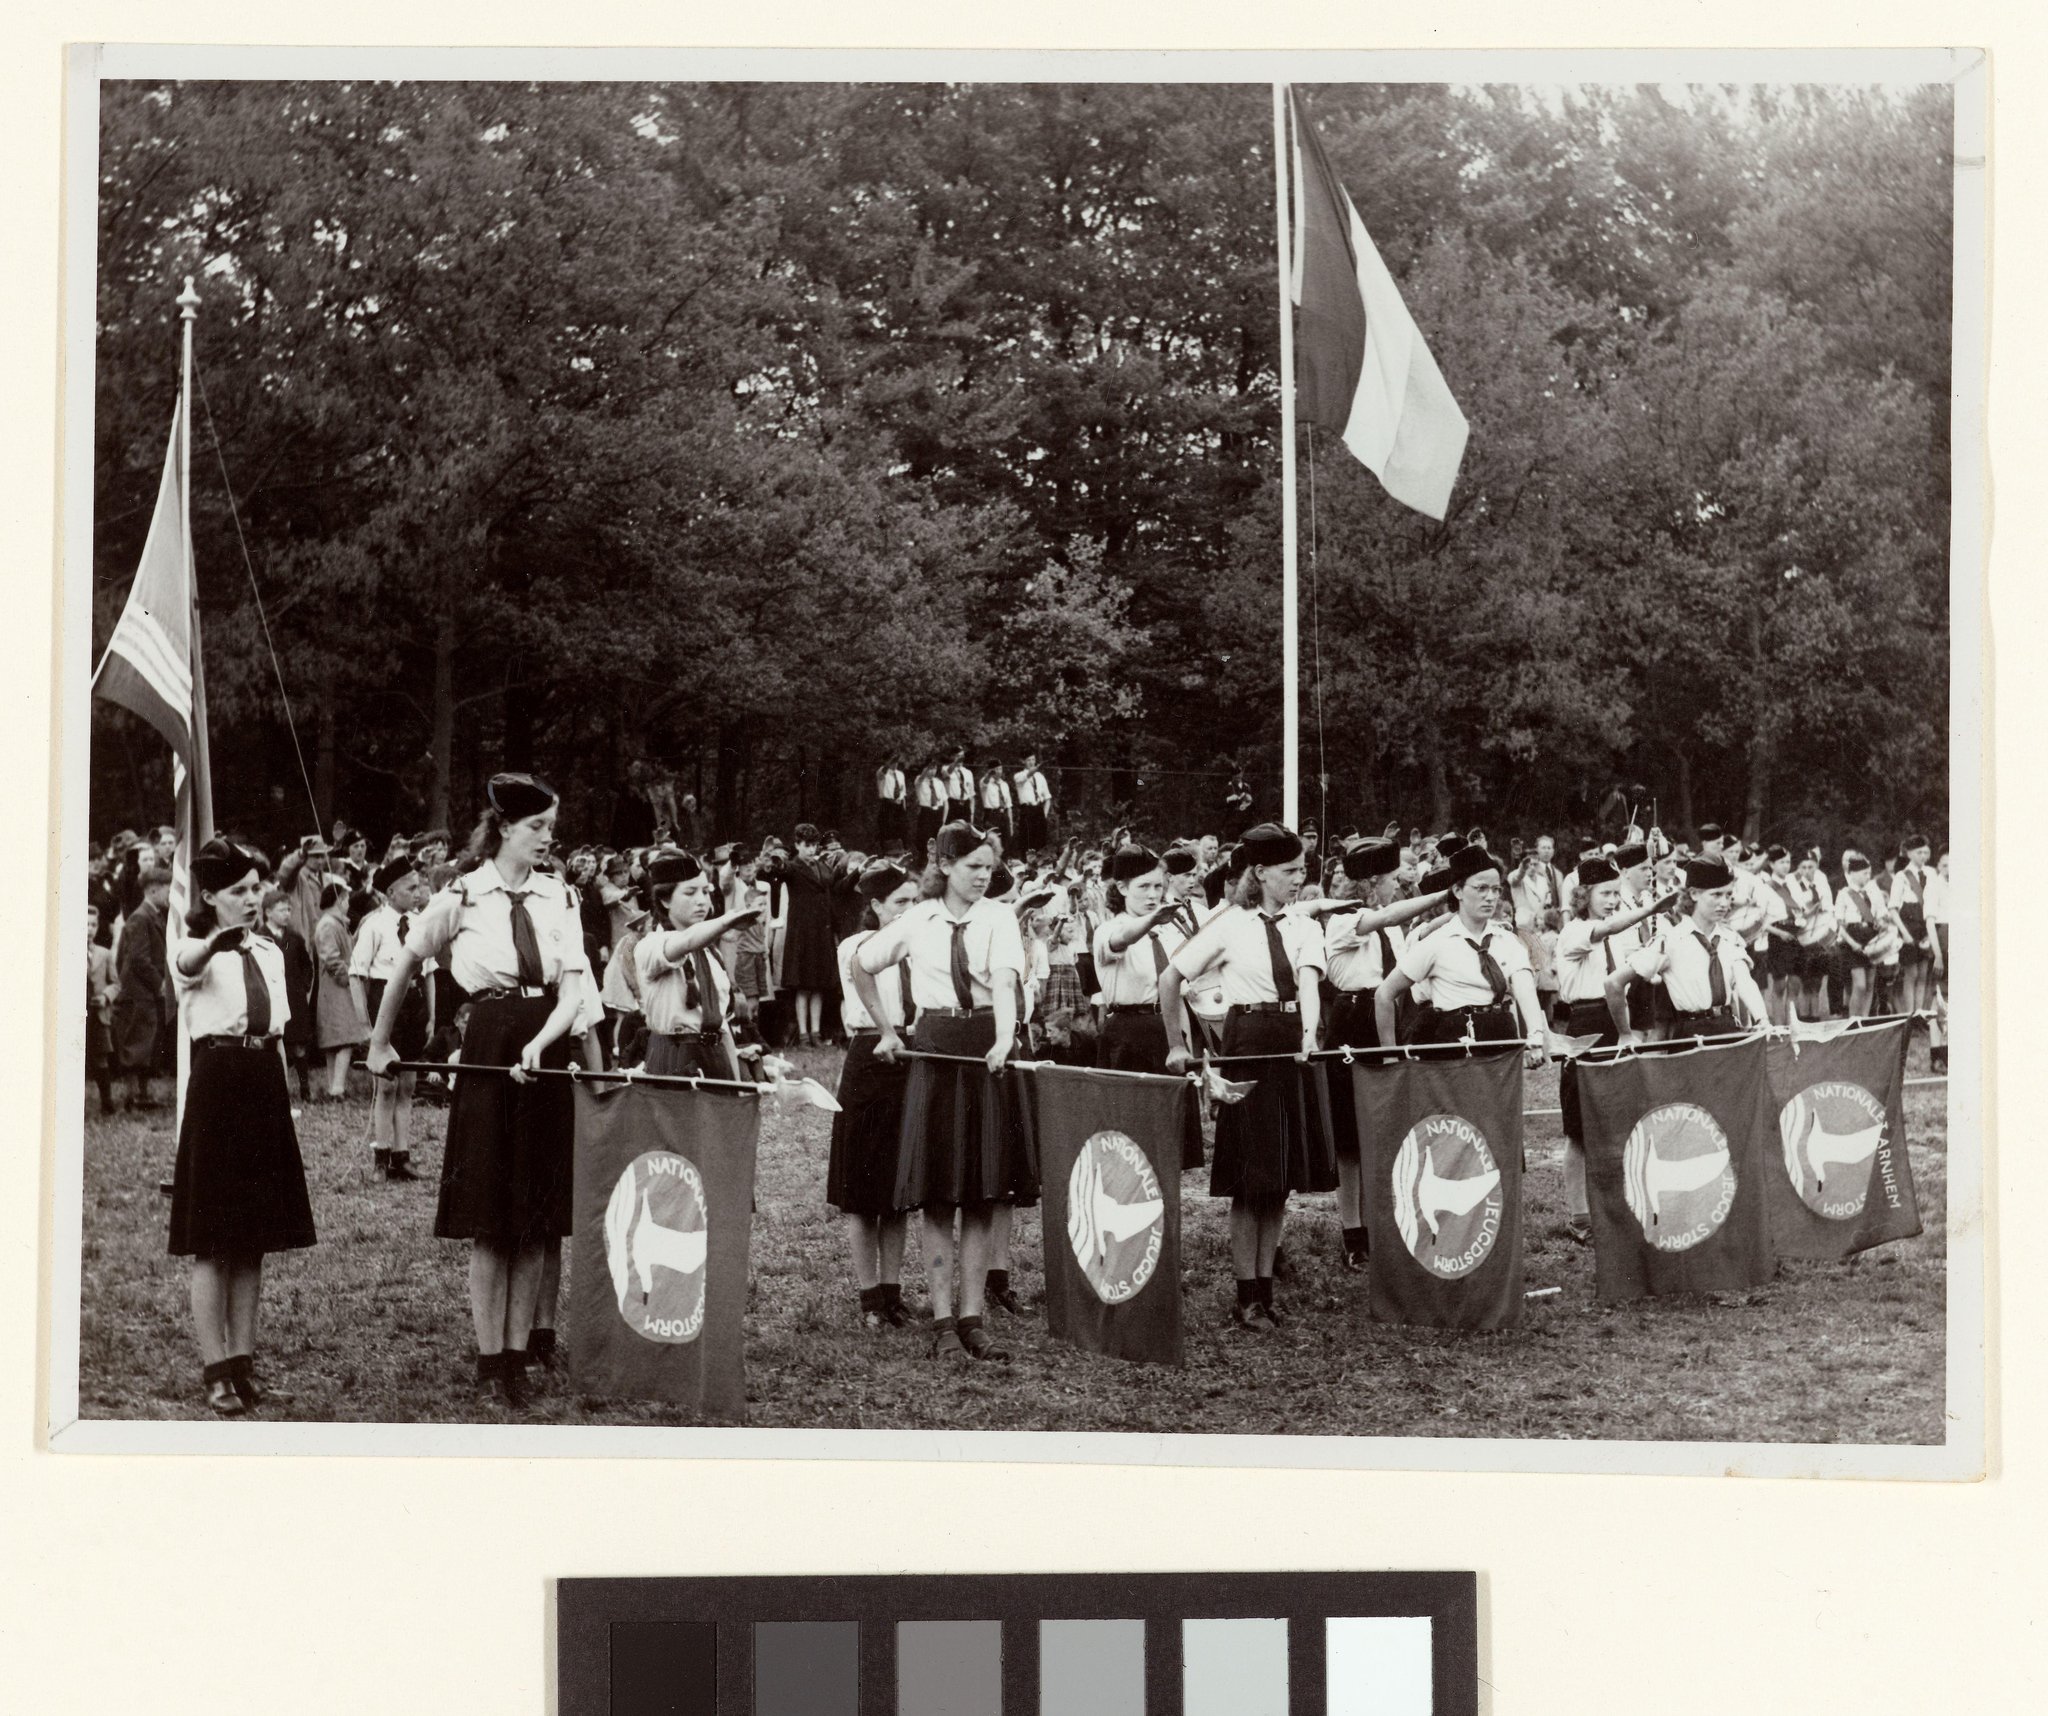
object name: photograph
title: Jeugdstorm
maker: antonius philippus de keijzer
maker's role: fotograaf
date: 1934-1943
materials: photographic support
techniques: photography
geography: zeist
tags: military celebrations, zeist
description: Rij meisjes van de jeugdstorm in uniform op een Velddag in Zeist. Vijf dragen de Jeugdstormvlag met de vliegende meeuw, de overigen brengen de NSB groet. Achter hen de Nederlandse vlag en die van de Jeugdstorm. Links jongens en meisjes in gewone kleren, rechts groep jongens van de Jeugdstorm in uniform met trommels. Op de achtergrond bomen. Het bijschrift vermeldt dat dit het slot is van de Velddag op Hemelvaartsdag, het 6de couplet van het Wilhelmus werd gezongen. De dag was georganiseerd door het Gewest Nedersticht (prov. Utrecht), er namen ca. 1400 leden aan deel.